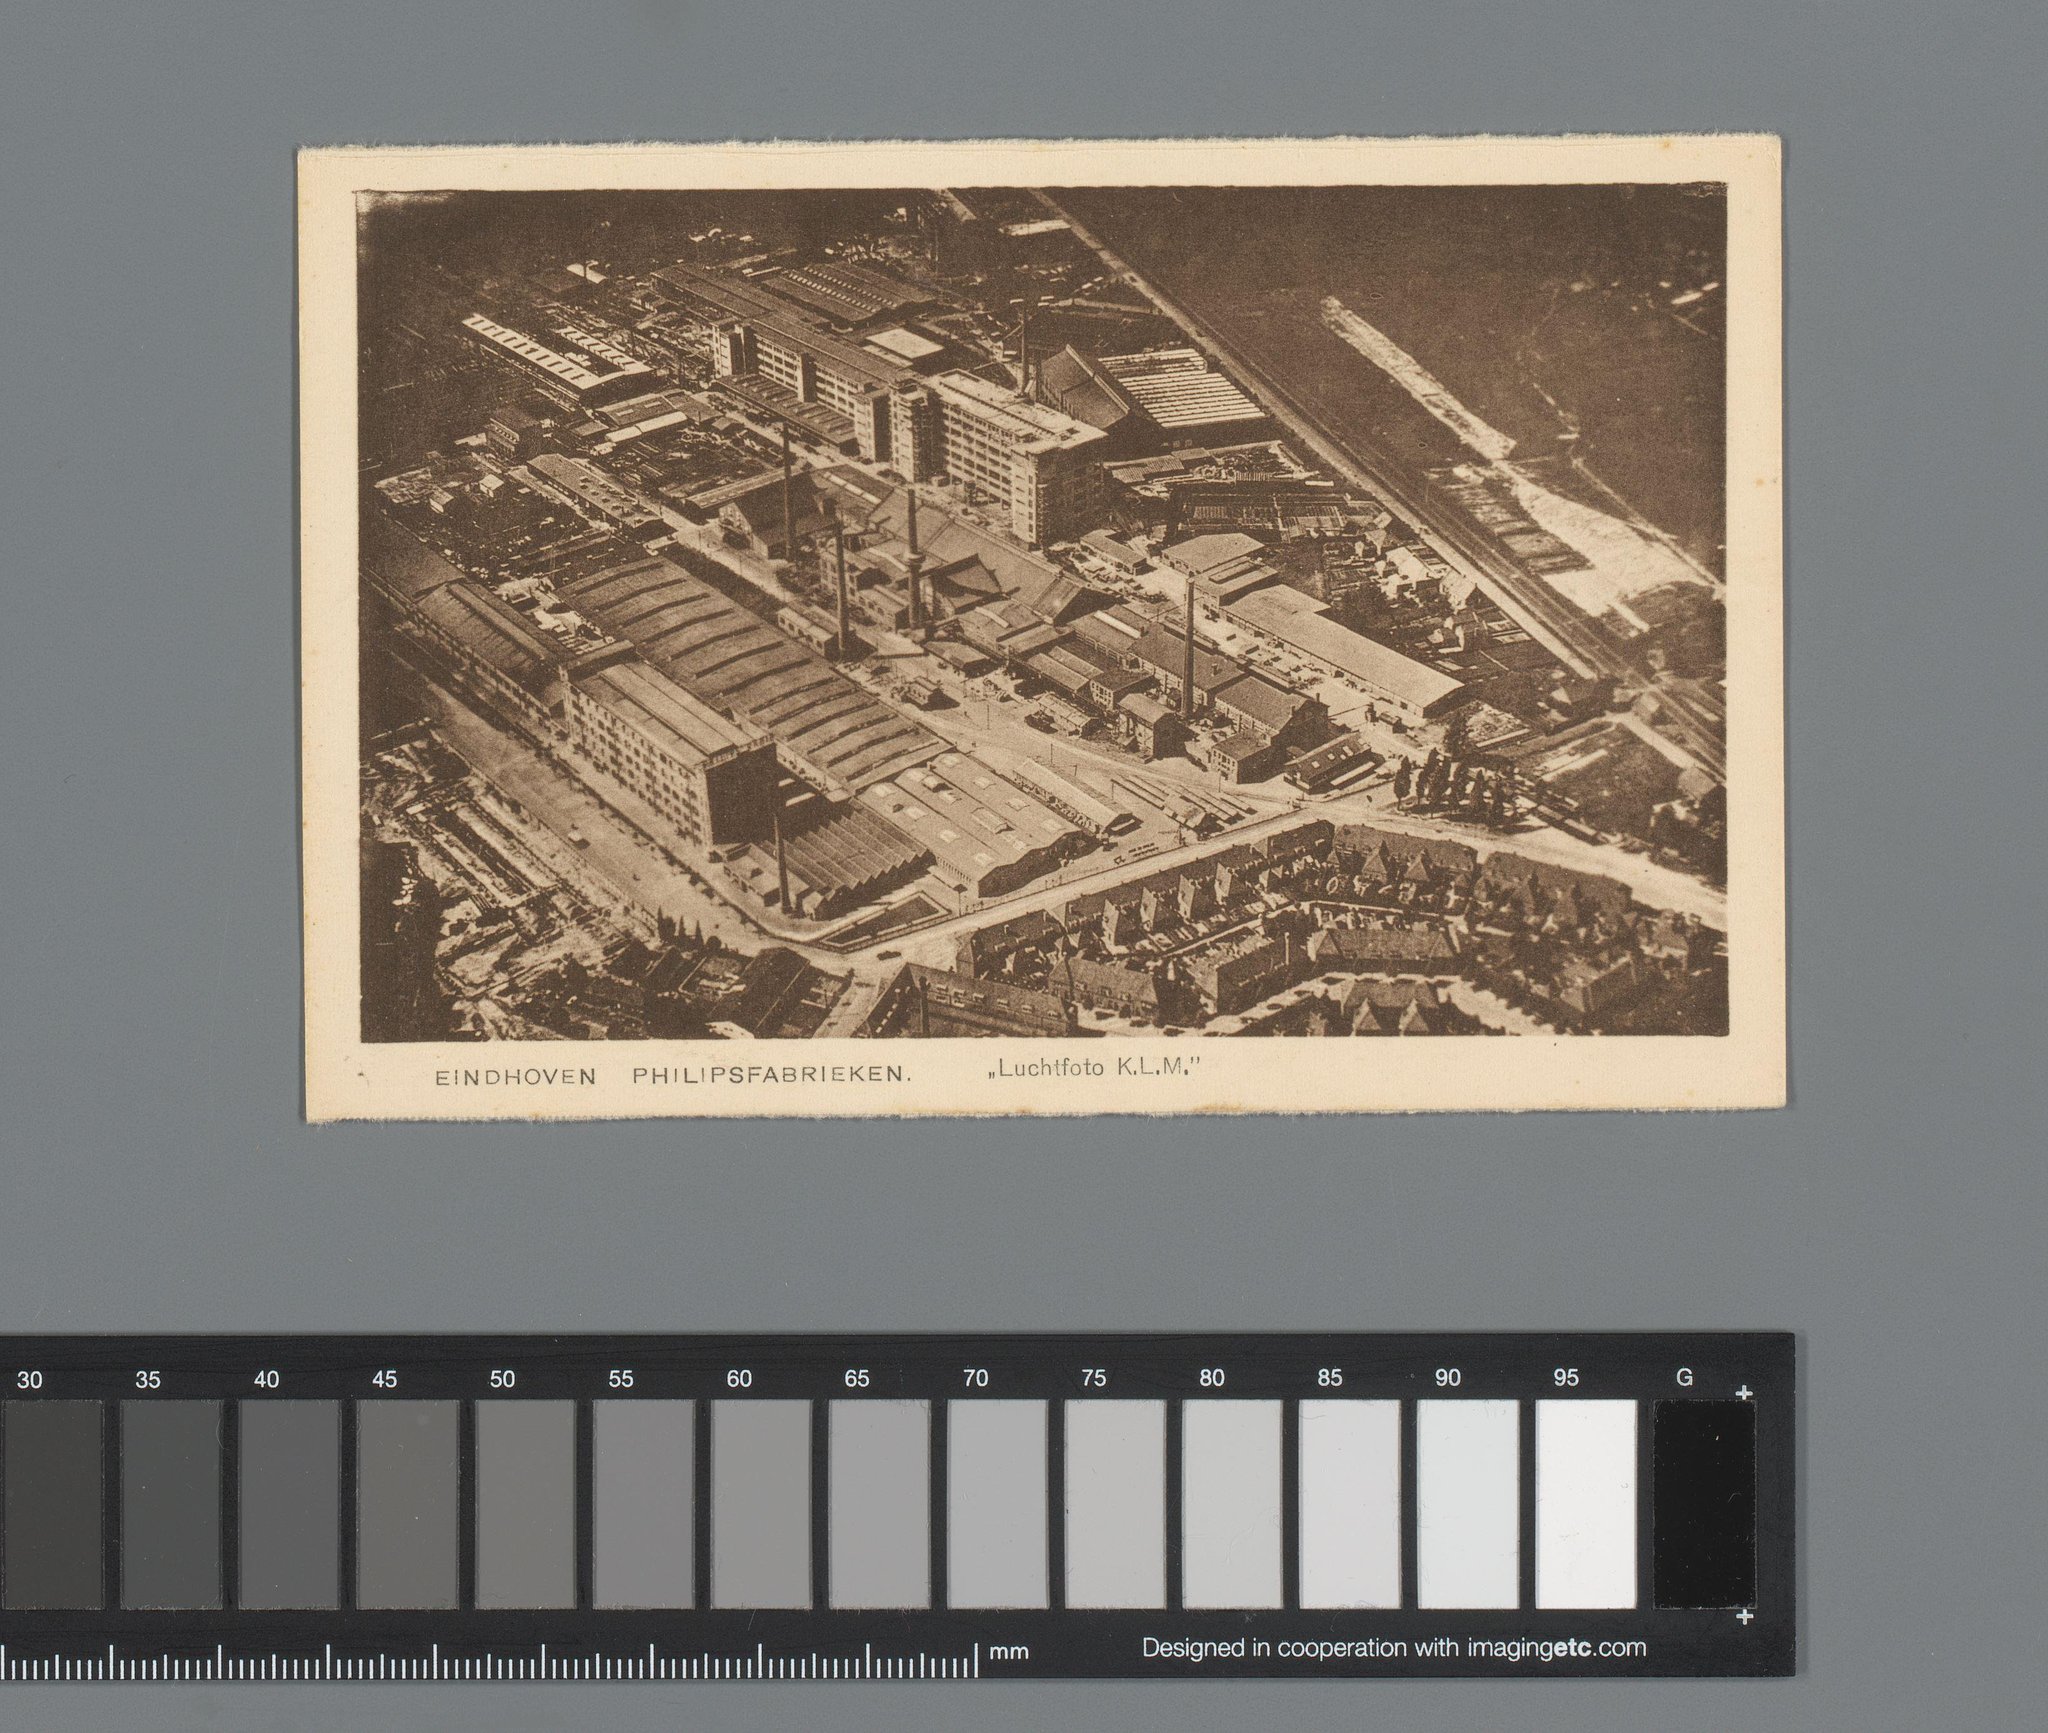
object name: ansichtkaart, prentbriefkaart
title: Eindhoven Philipsfabrieken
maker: Anonymous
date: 1923-1970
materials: paper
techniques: photograph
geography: baarn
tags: factory in landscape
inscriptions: number: ‘0322H/ 9184’